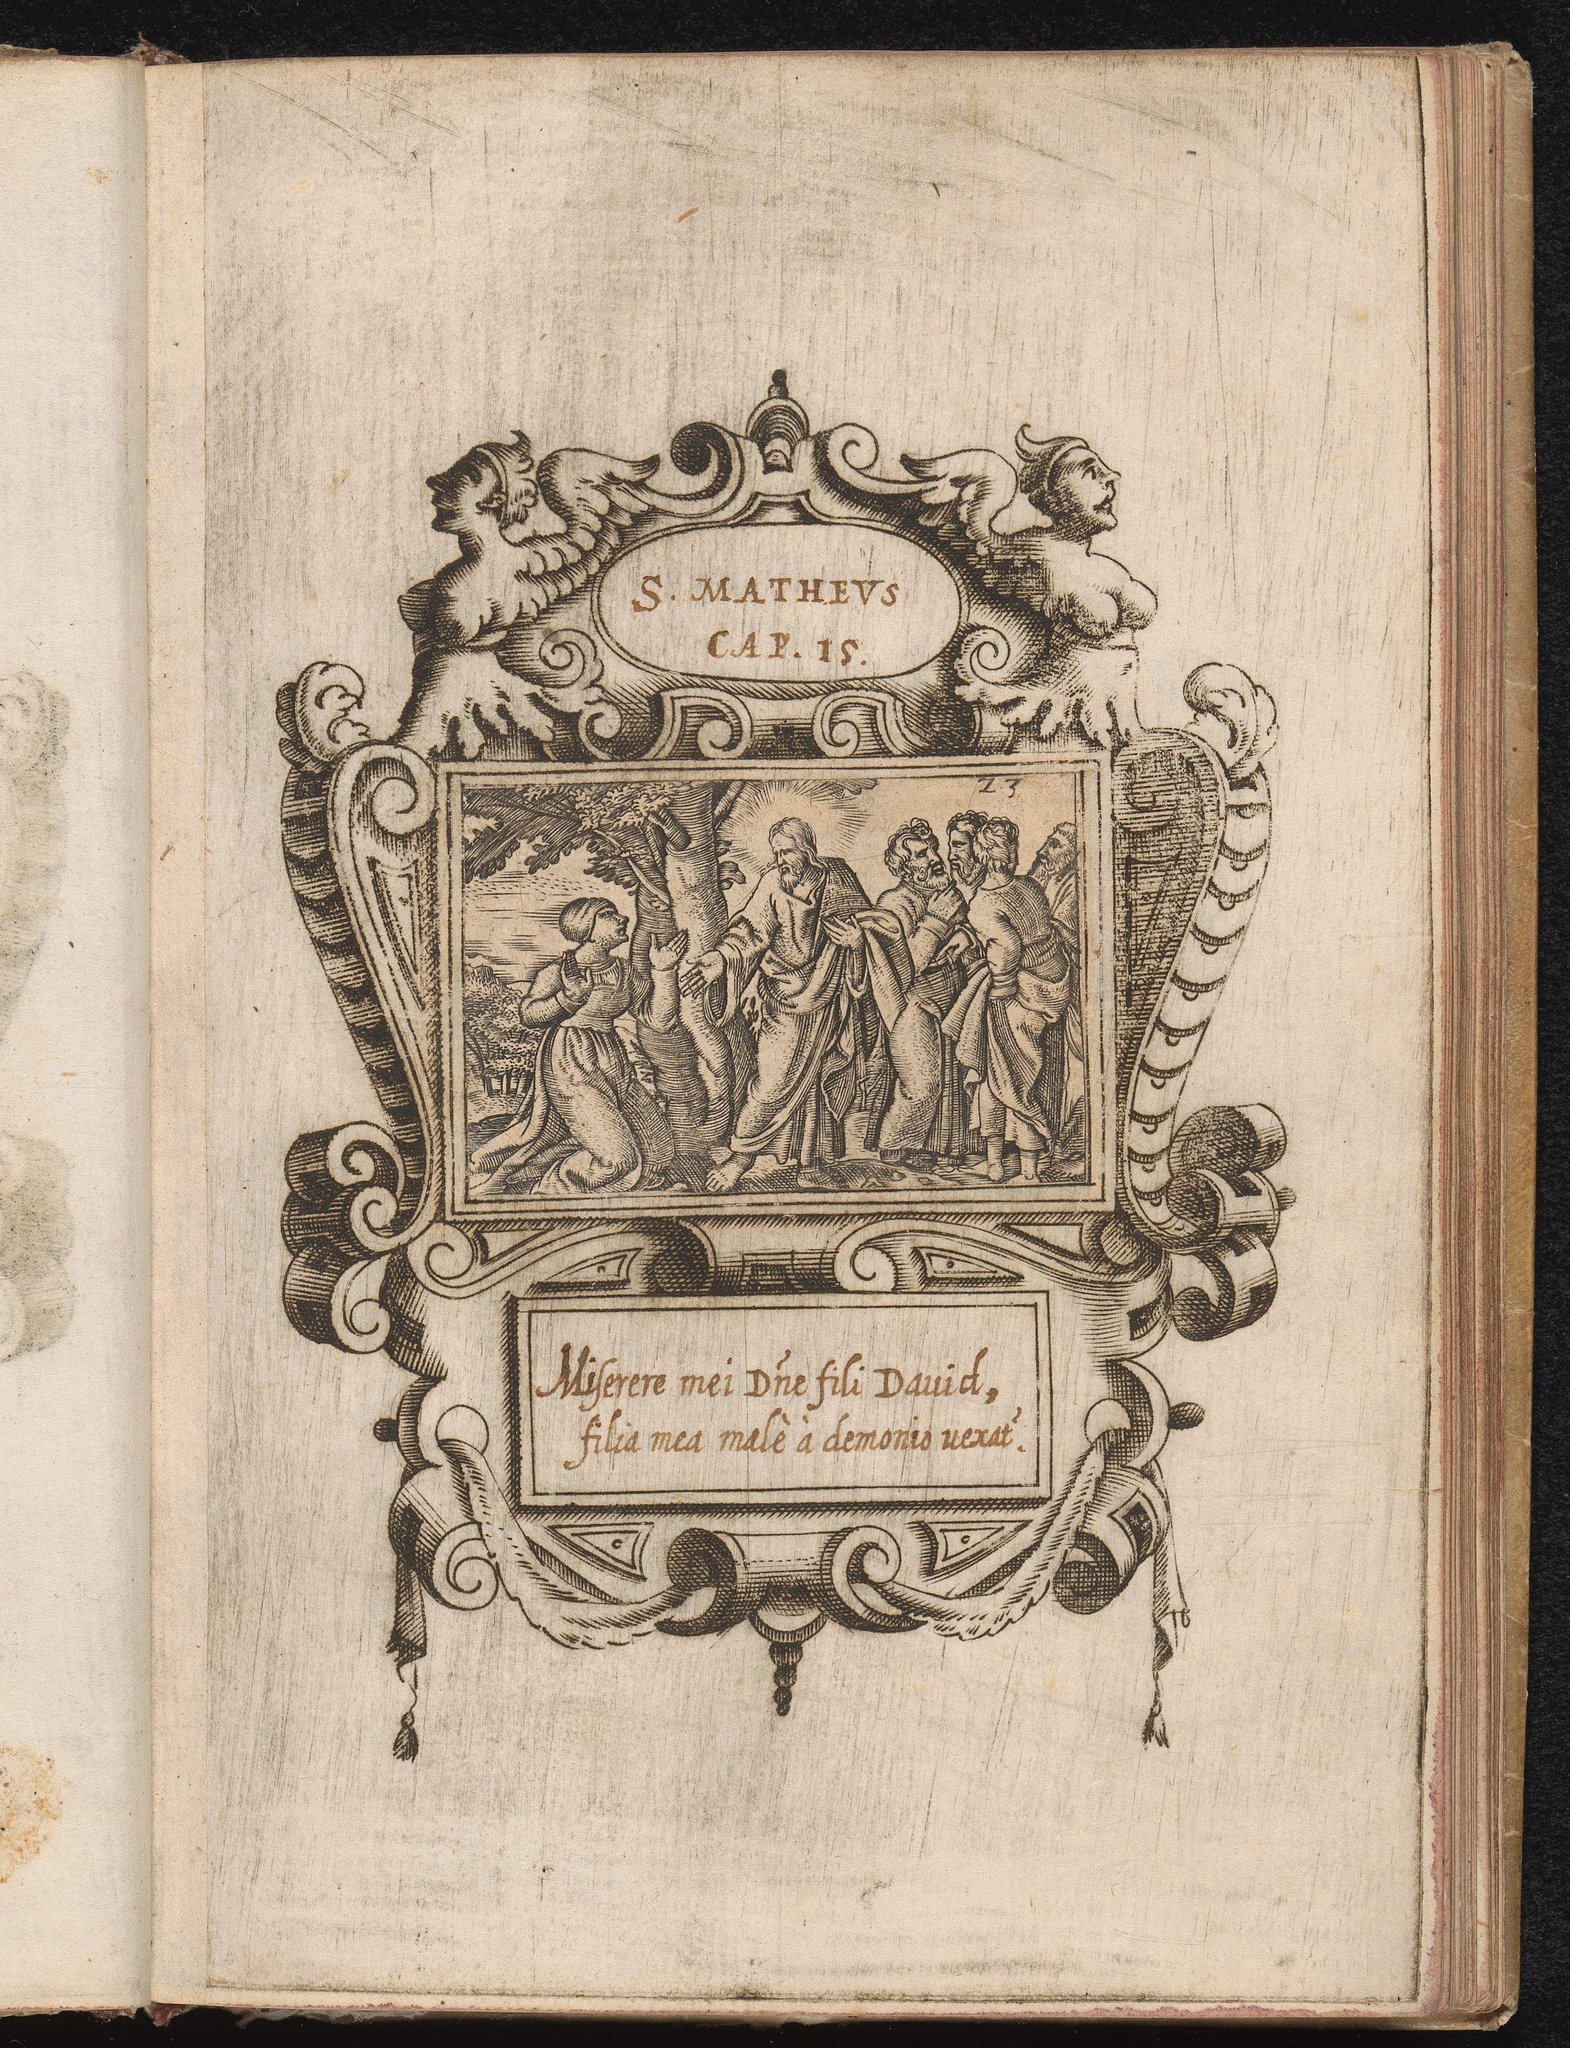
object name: print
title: Het leven van Christus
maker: Anonymous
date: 1570-1610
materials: paper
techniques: engraving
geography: antwerp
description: Christus geneest de bloedvloeiende vrouw. Onderdeel van een prentalbum met titelprent en 56 scènes uit het Nieuwe Testament. Elke voorstelling gemonteerd in een gravure met ornamentele cartouches waarin een venster is gesneden en voorzien van handgeschreven bijbelpassages.